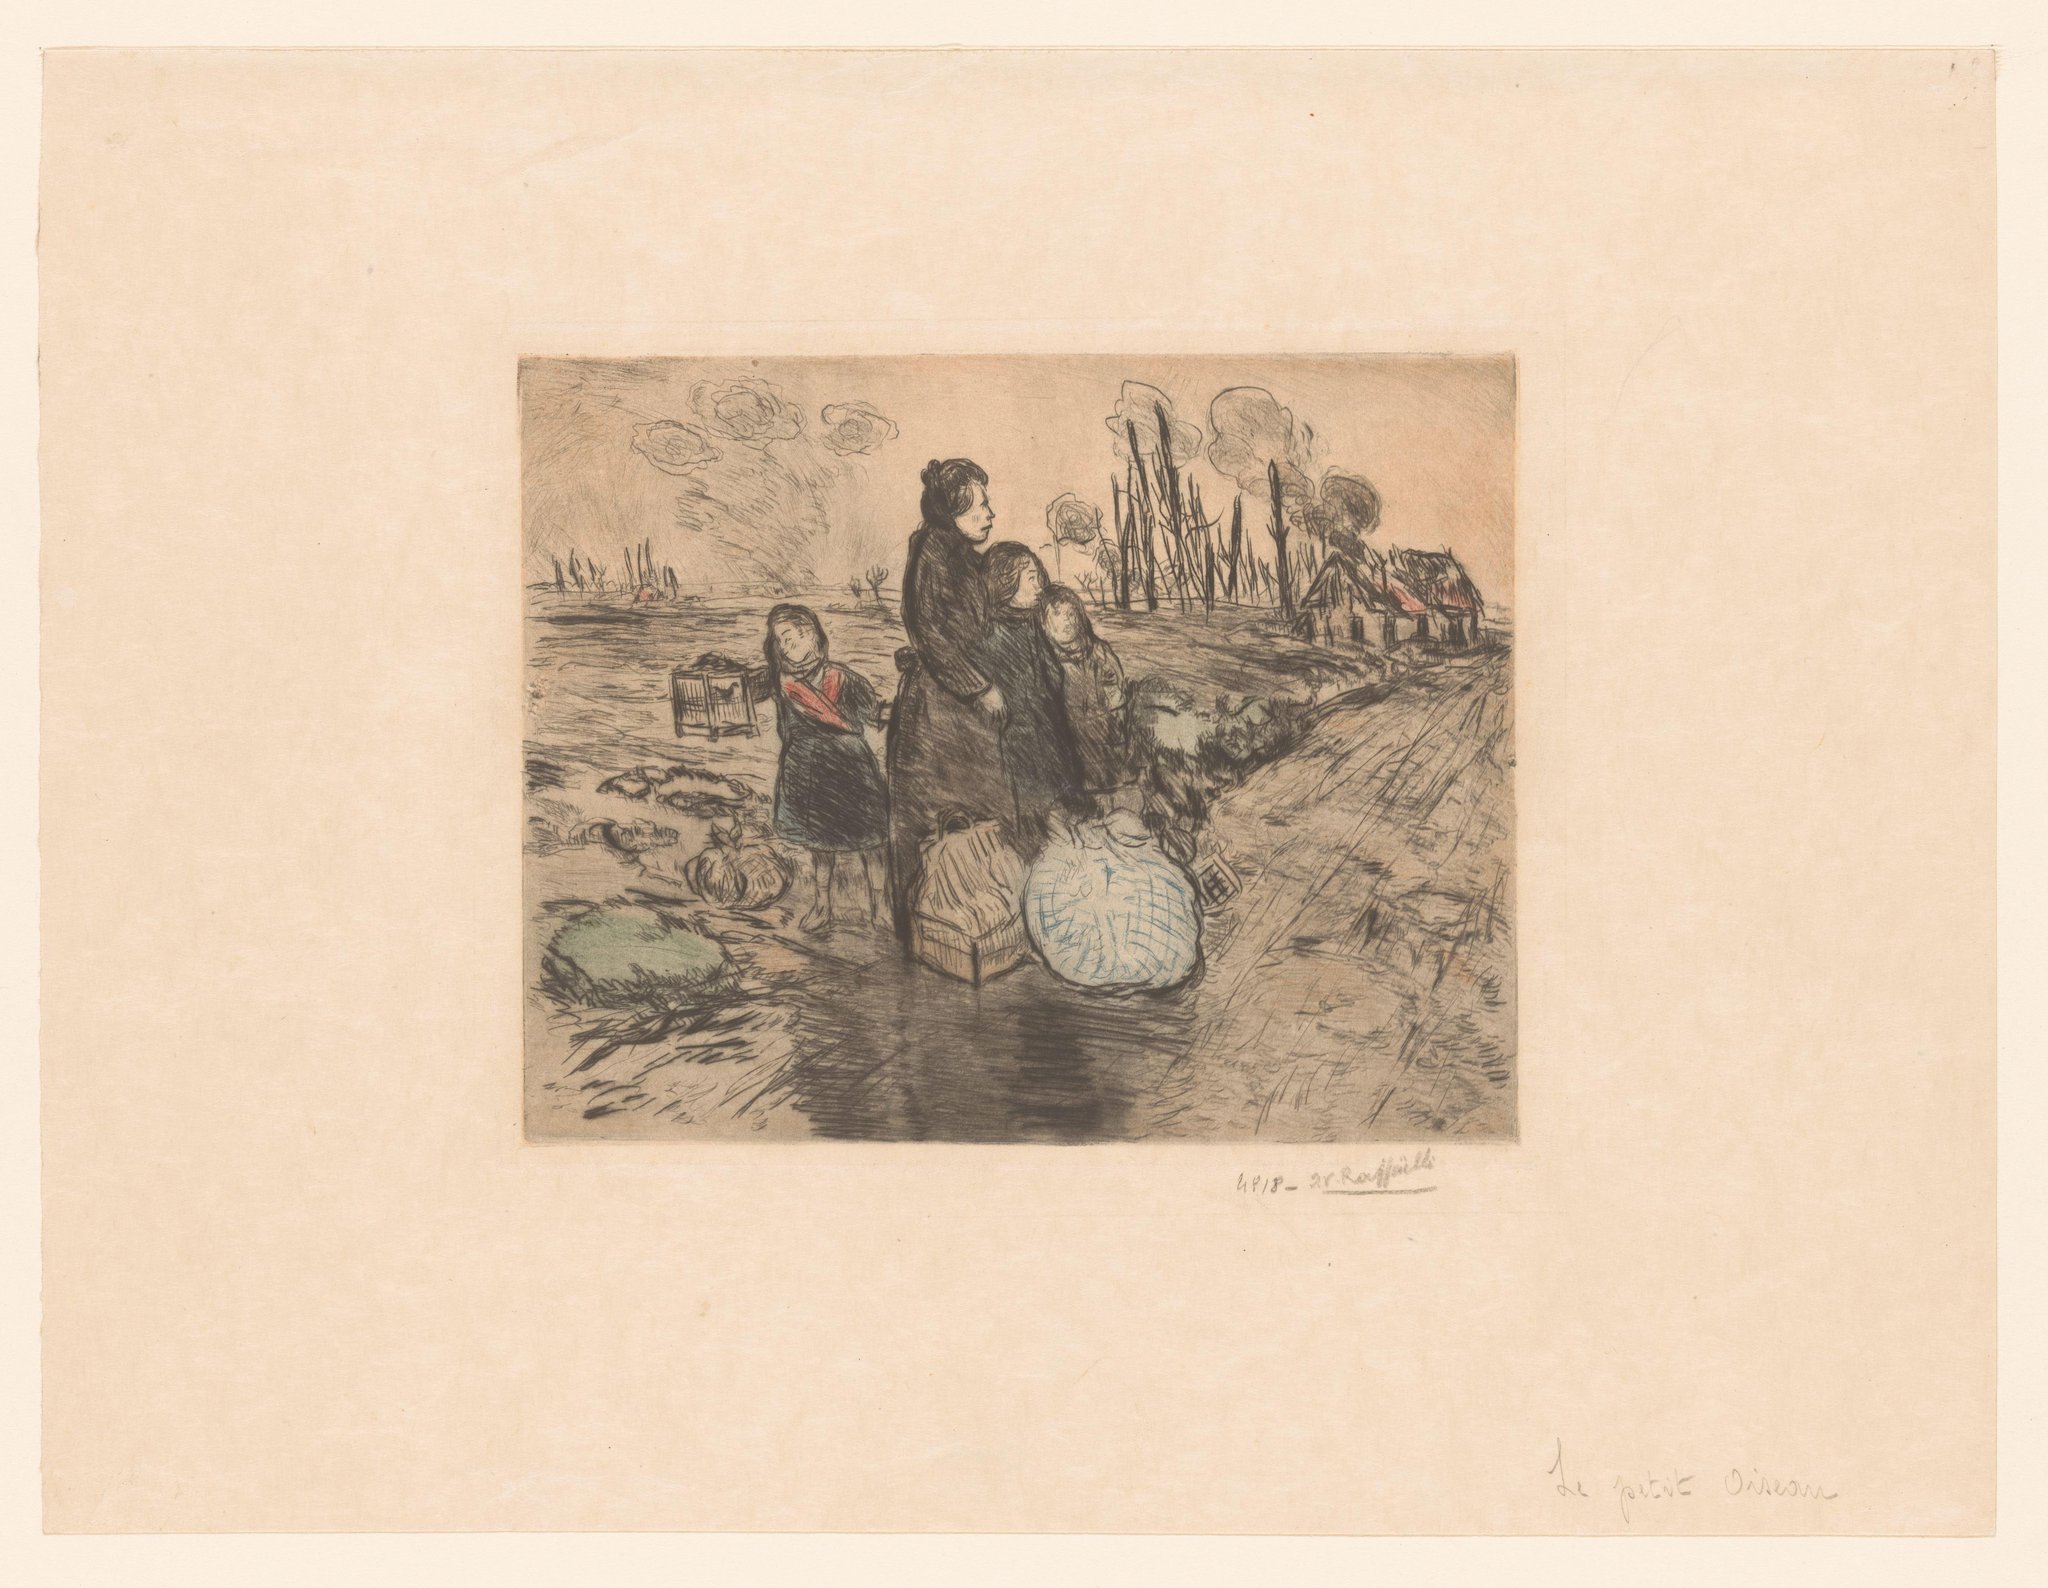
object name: print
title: Le petit oiseau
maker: jean françois raffaëlli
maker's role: print maker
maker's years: 1850-1924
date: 1860-1924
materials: paper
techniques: drypoint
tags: 'en route', traveller under way, mother and child(ren), woman and child(ren) (family group)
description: Vluchtelingen met hun bezittingen op een weg, één meisje houdt een kooitje met een vogel erin vast.